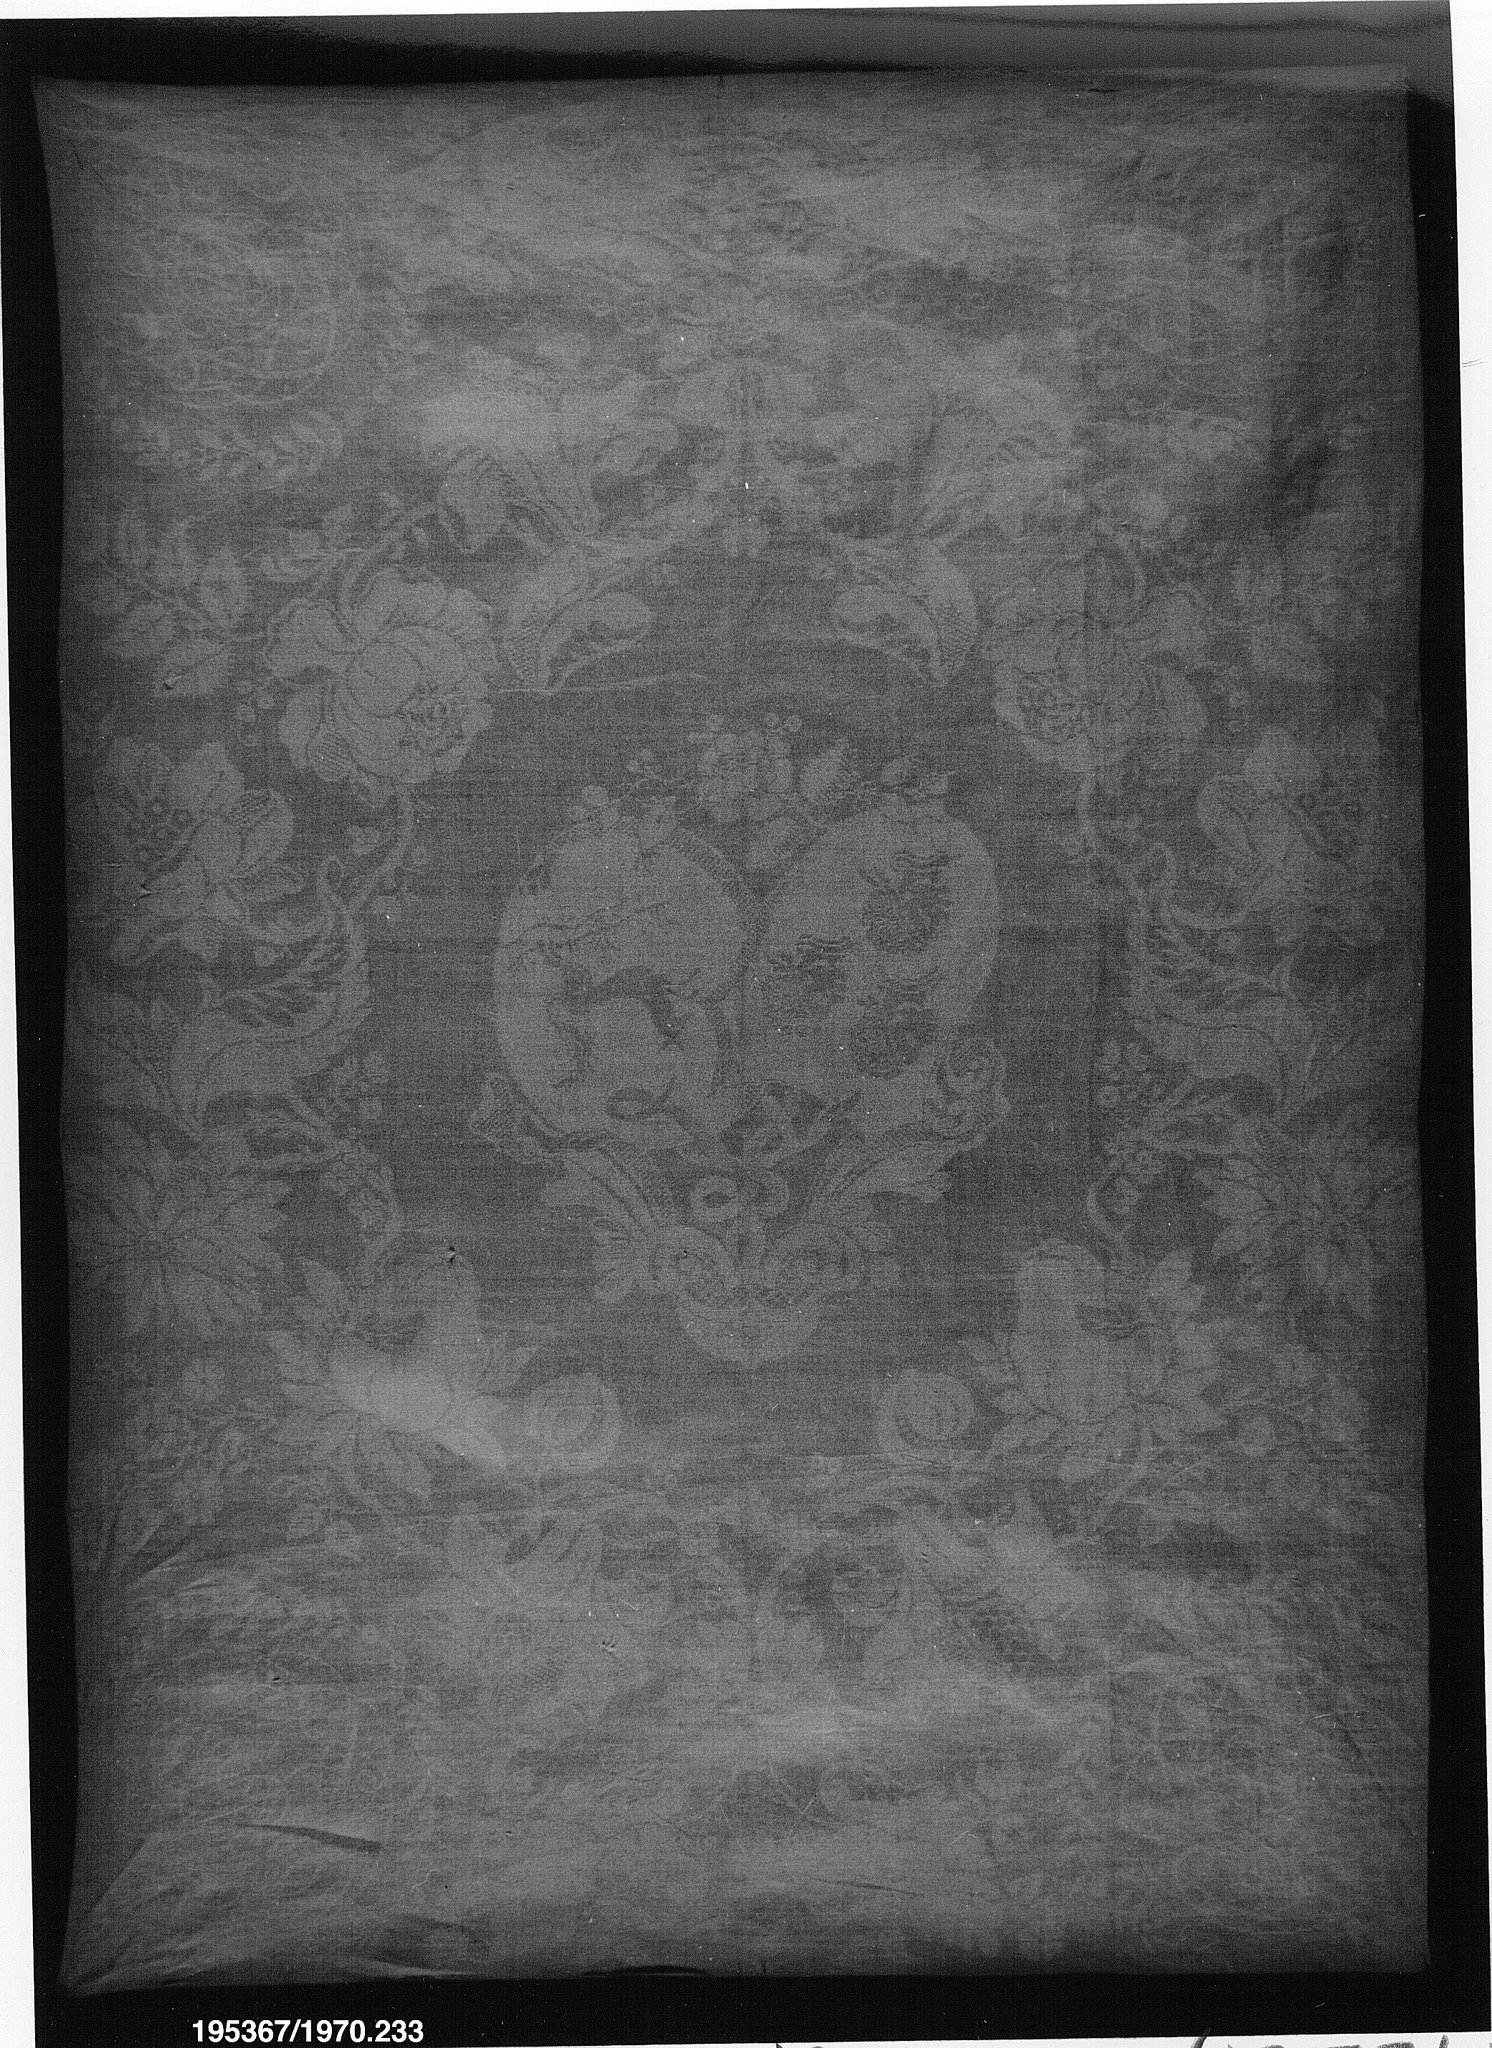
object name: napkin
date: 1745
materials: linen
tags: flowers